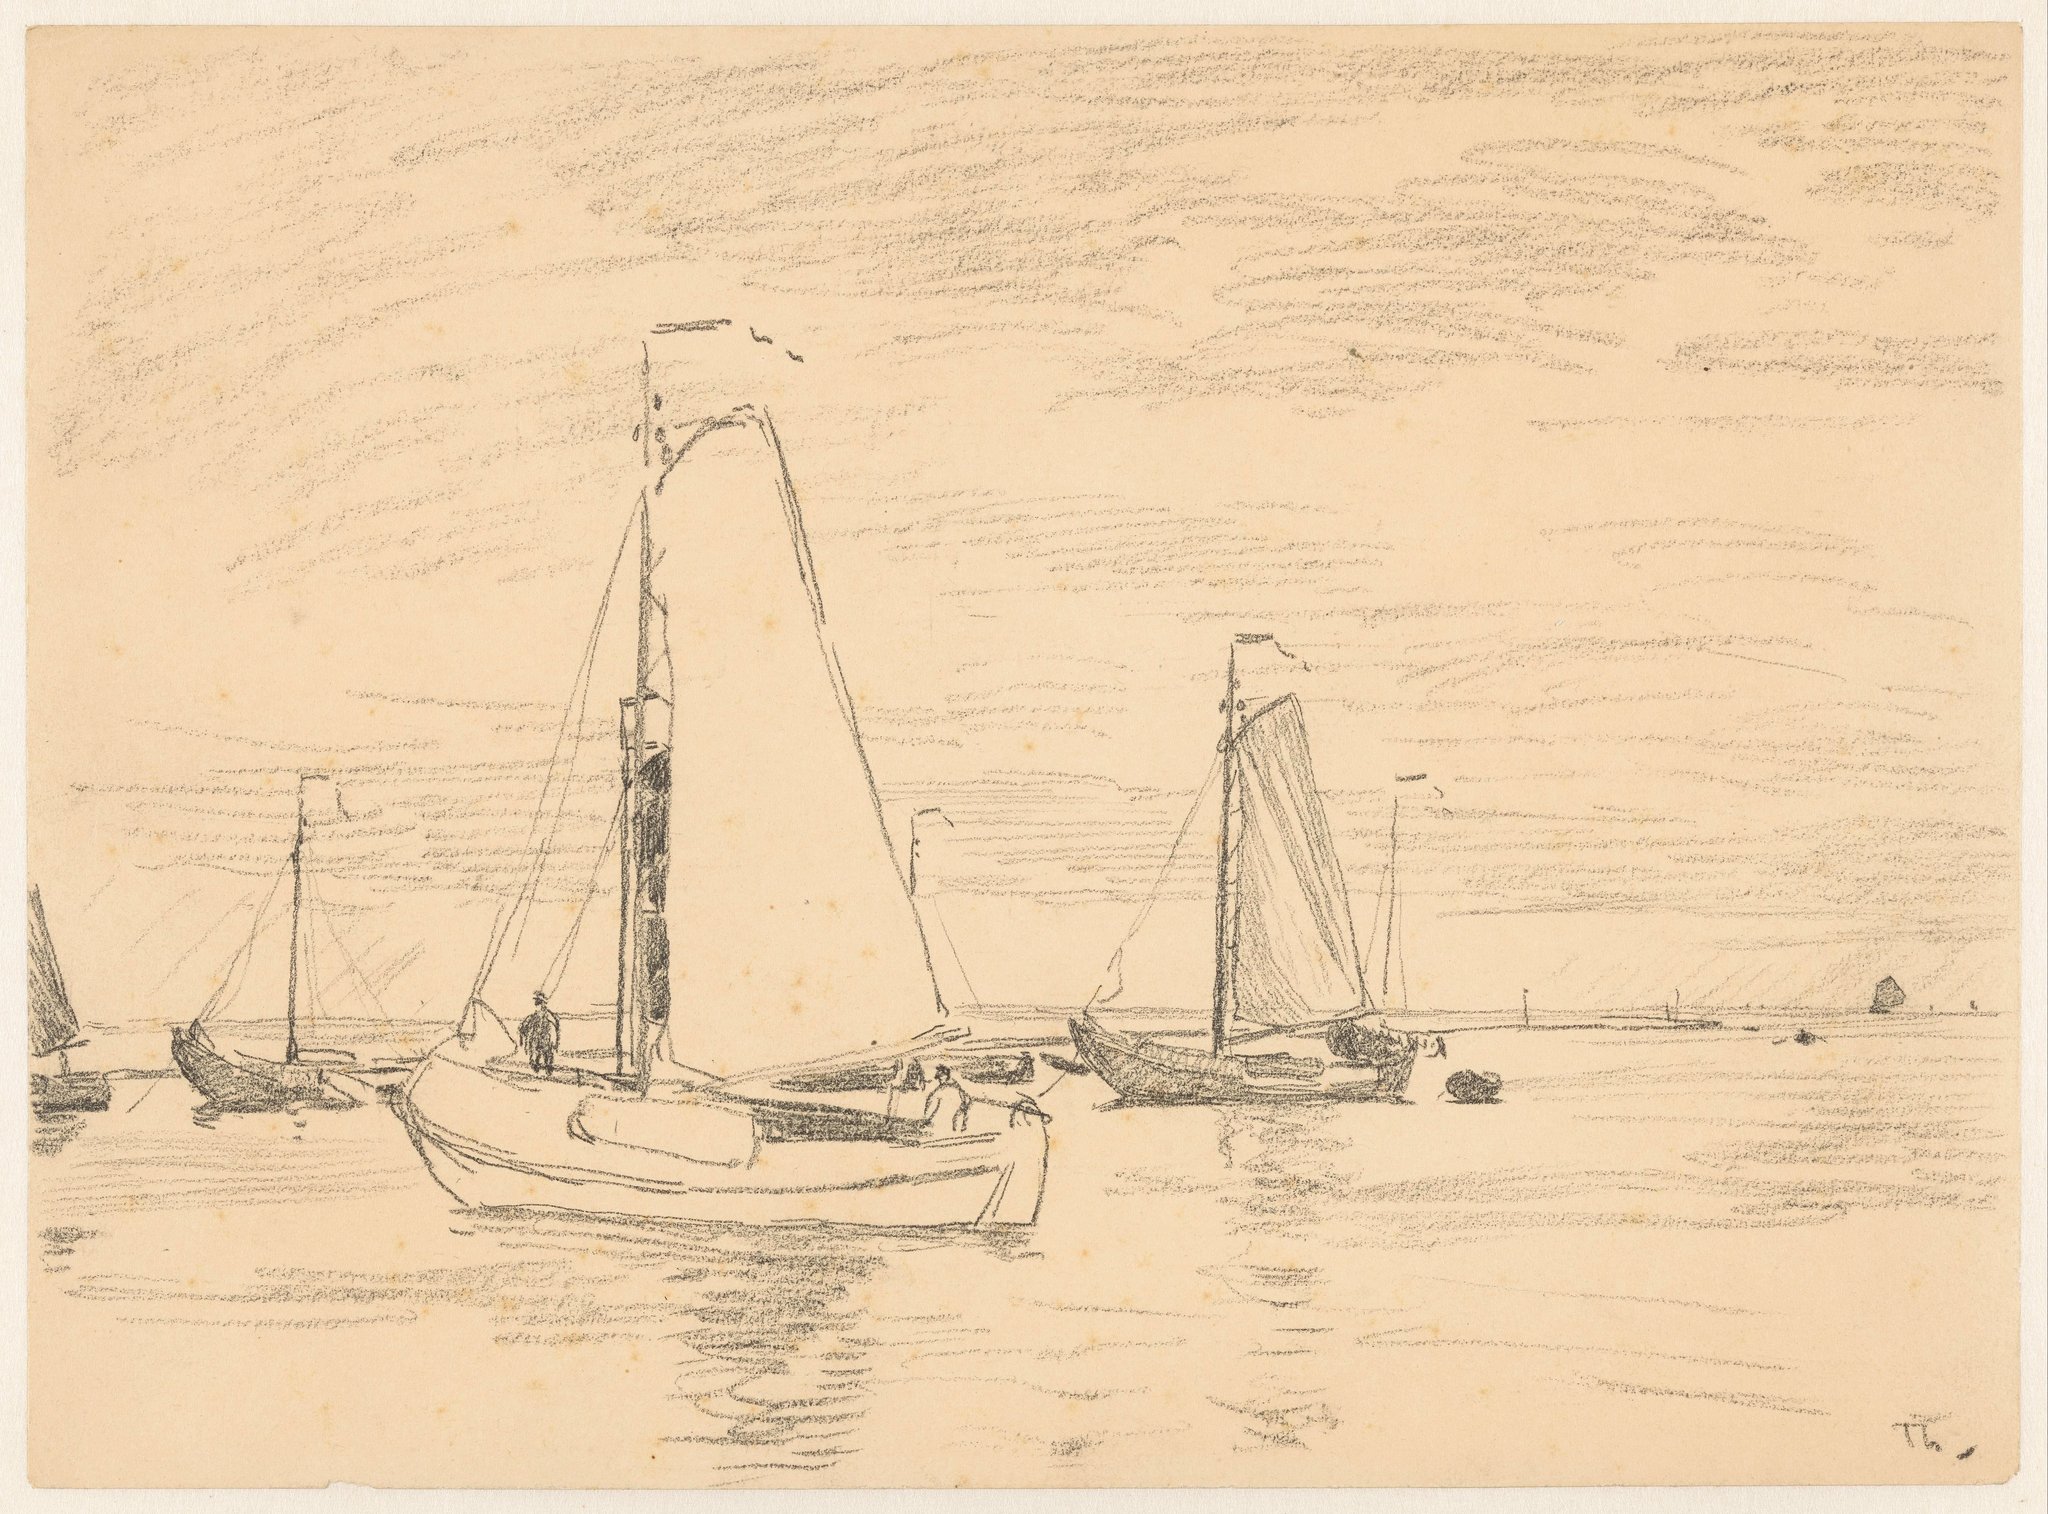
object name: drawing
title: Botters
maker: willem bastiaan tholen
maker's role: draughtsman, painter, print maker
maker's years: 1860-1931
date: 1870-1931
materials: chalk, paper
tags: ships (in general) - cc - more than one ship